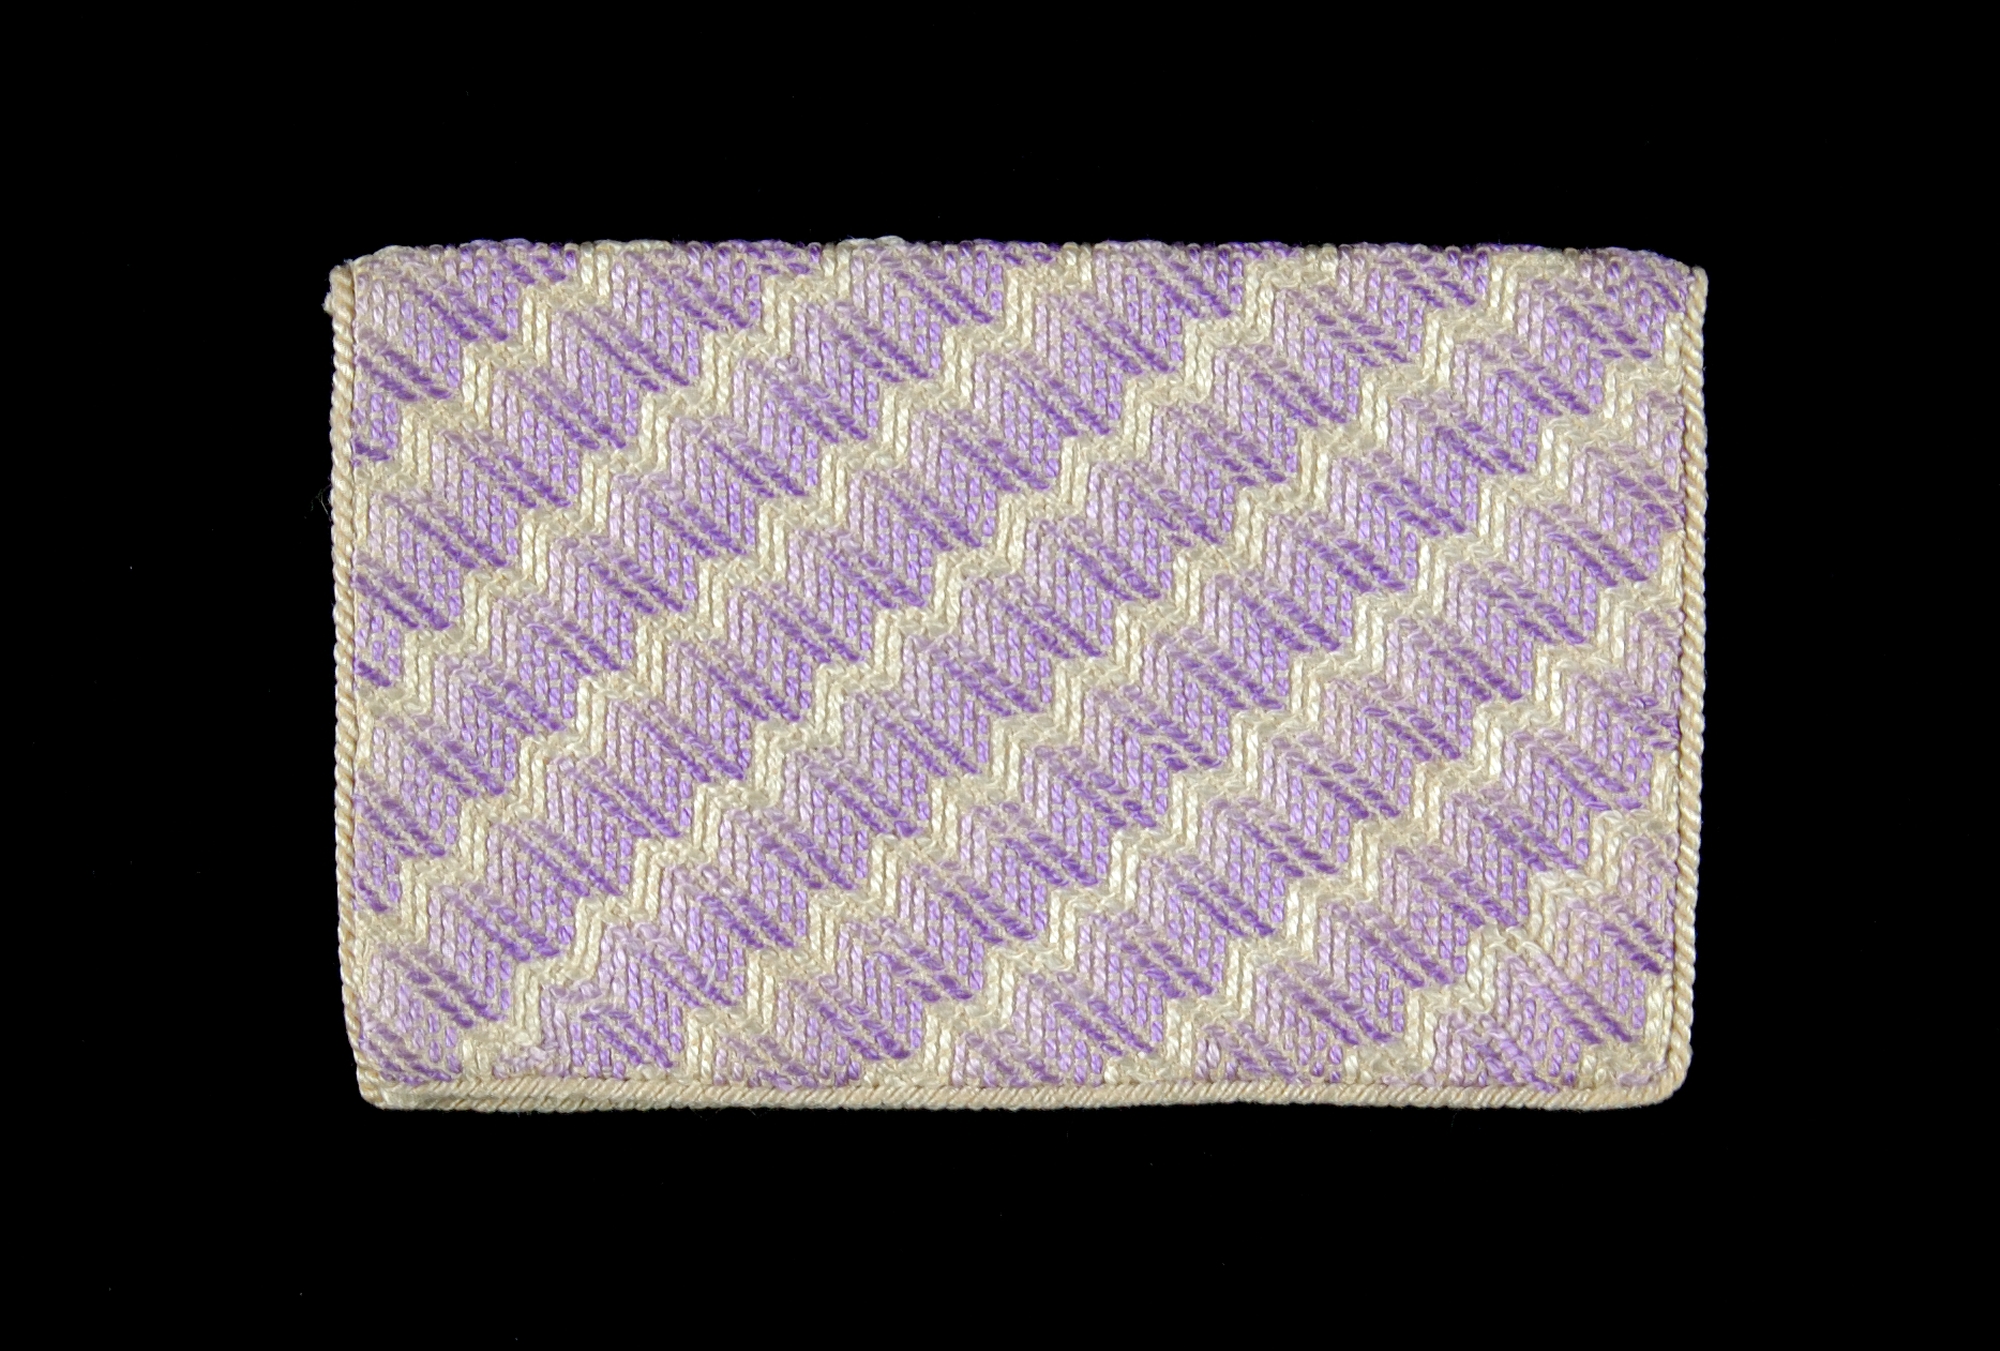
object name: card case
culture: american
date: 1801-1825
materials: silk